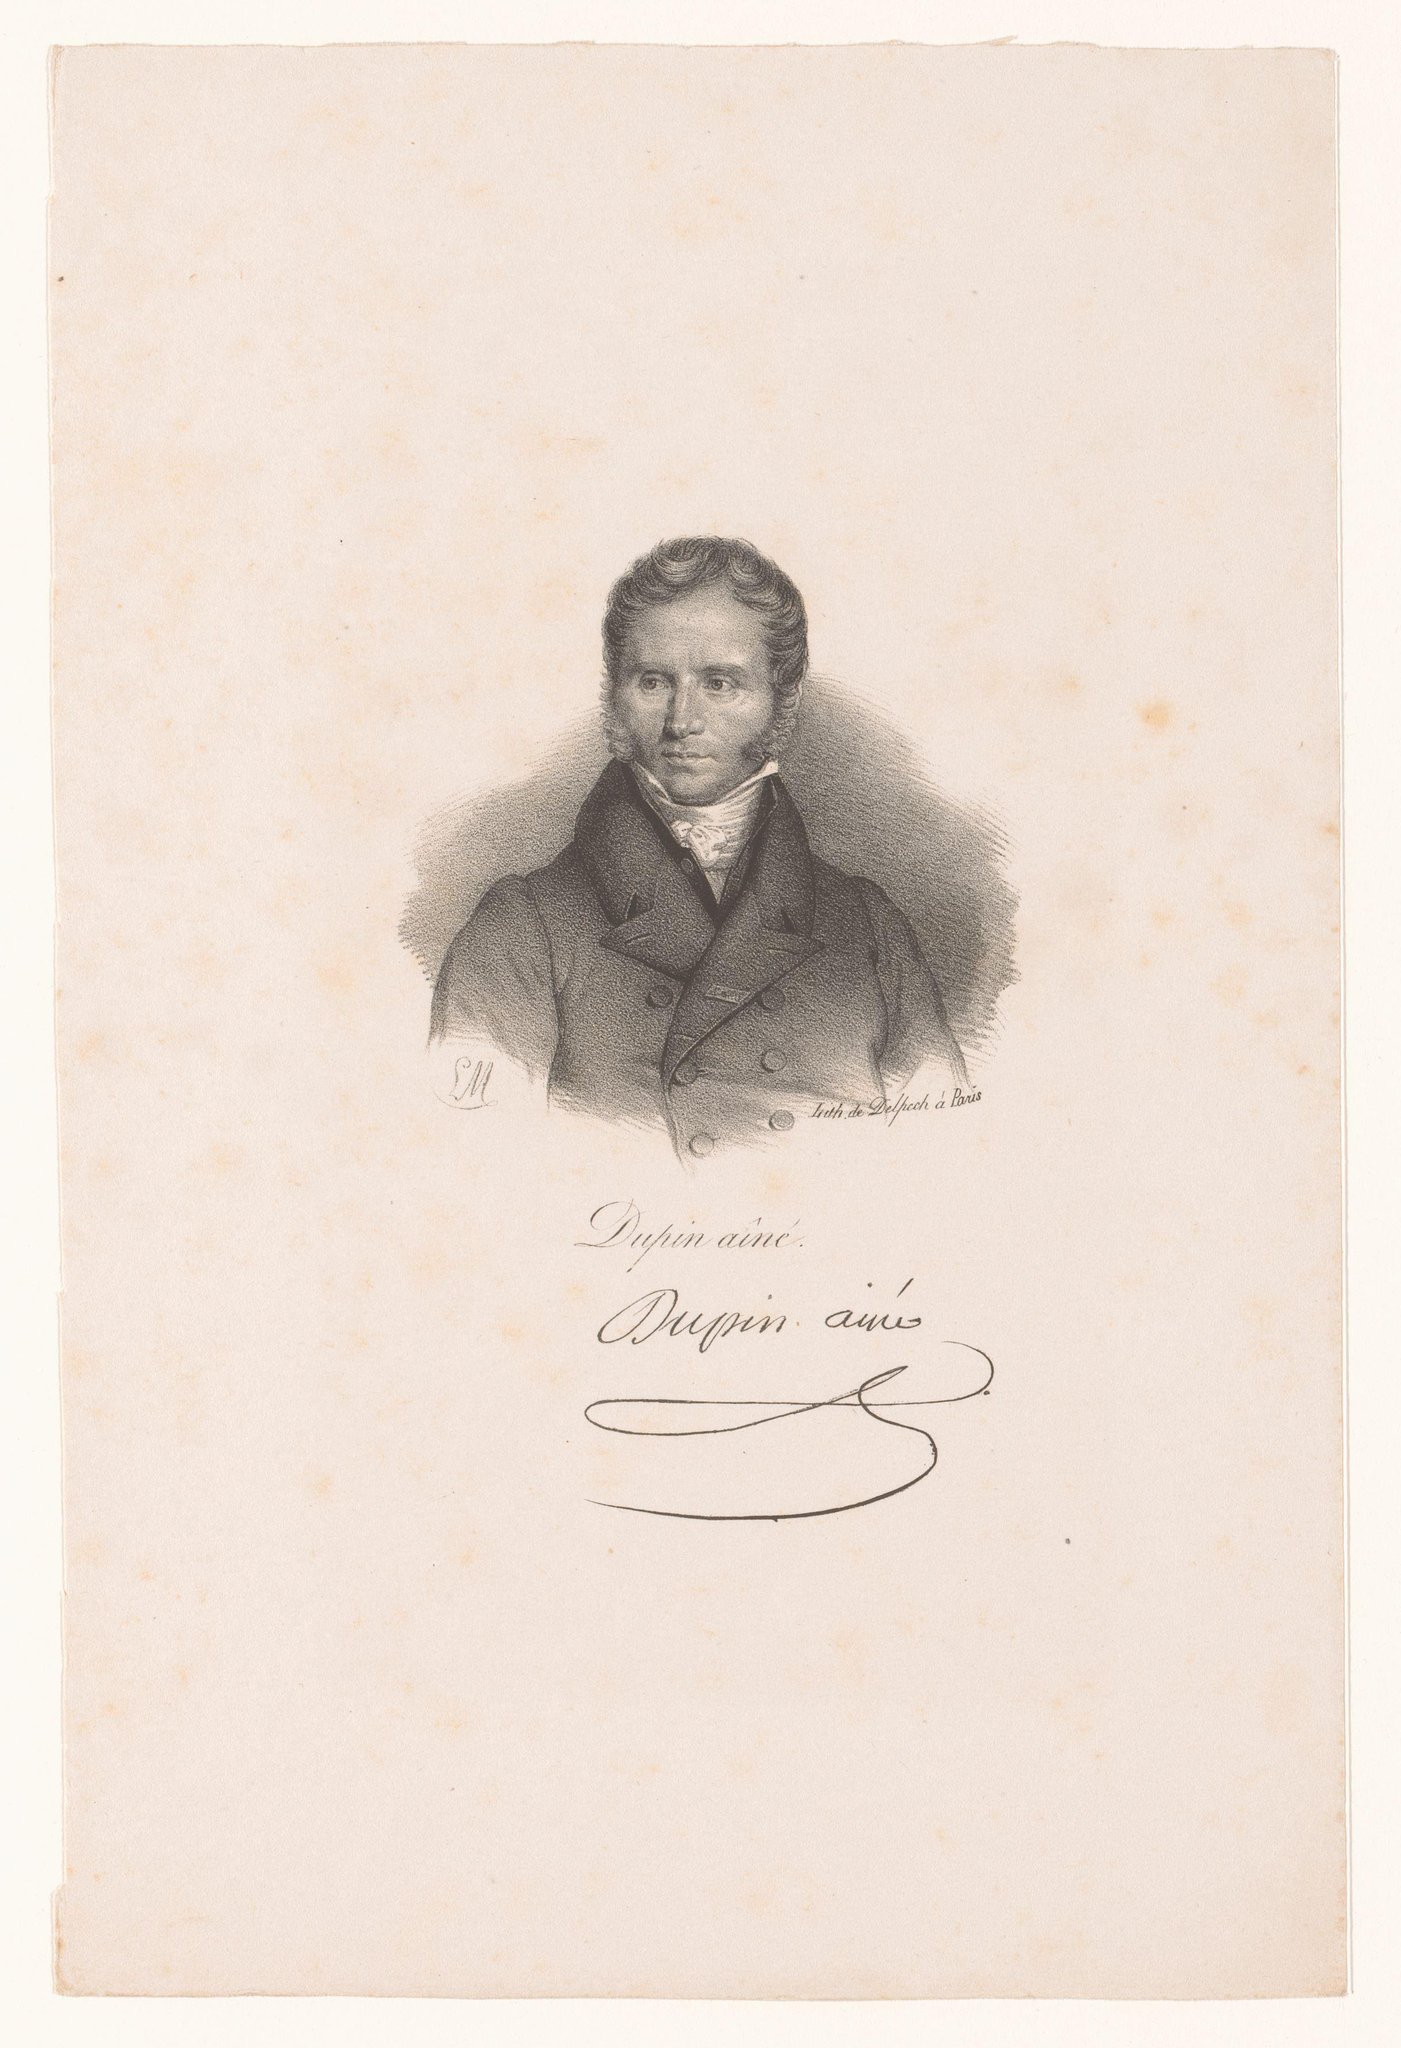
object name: print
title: Dupin aîné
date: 1825-1842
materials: paper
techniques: lithograph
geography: paris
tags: paris, historical persons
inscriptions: collector's mark: Lugt 2228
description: Prent waarschijnlijk gebruikt voor: Célébrités contemporaines ou portraits des personnes de notre époque (…). Parijs: veuve Delpech, 1842. En/of voor: Célébrités contemporaines ou portraits des personnes de notre époque (…). Parijs: Rosselin, 1845-1849. Mogelijk komt de prent ook voor in eerdere en/of latere publicaties uitgegeven door veuve Delpech of haar opvolger Rosselin.